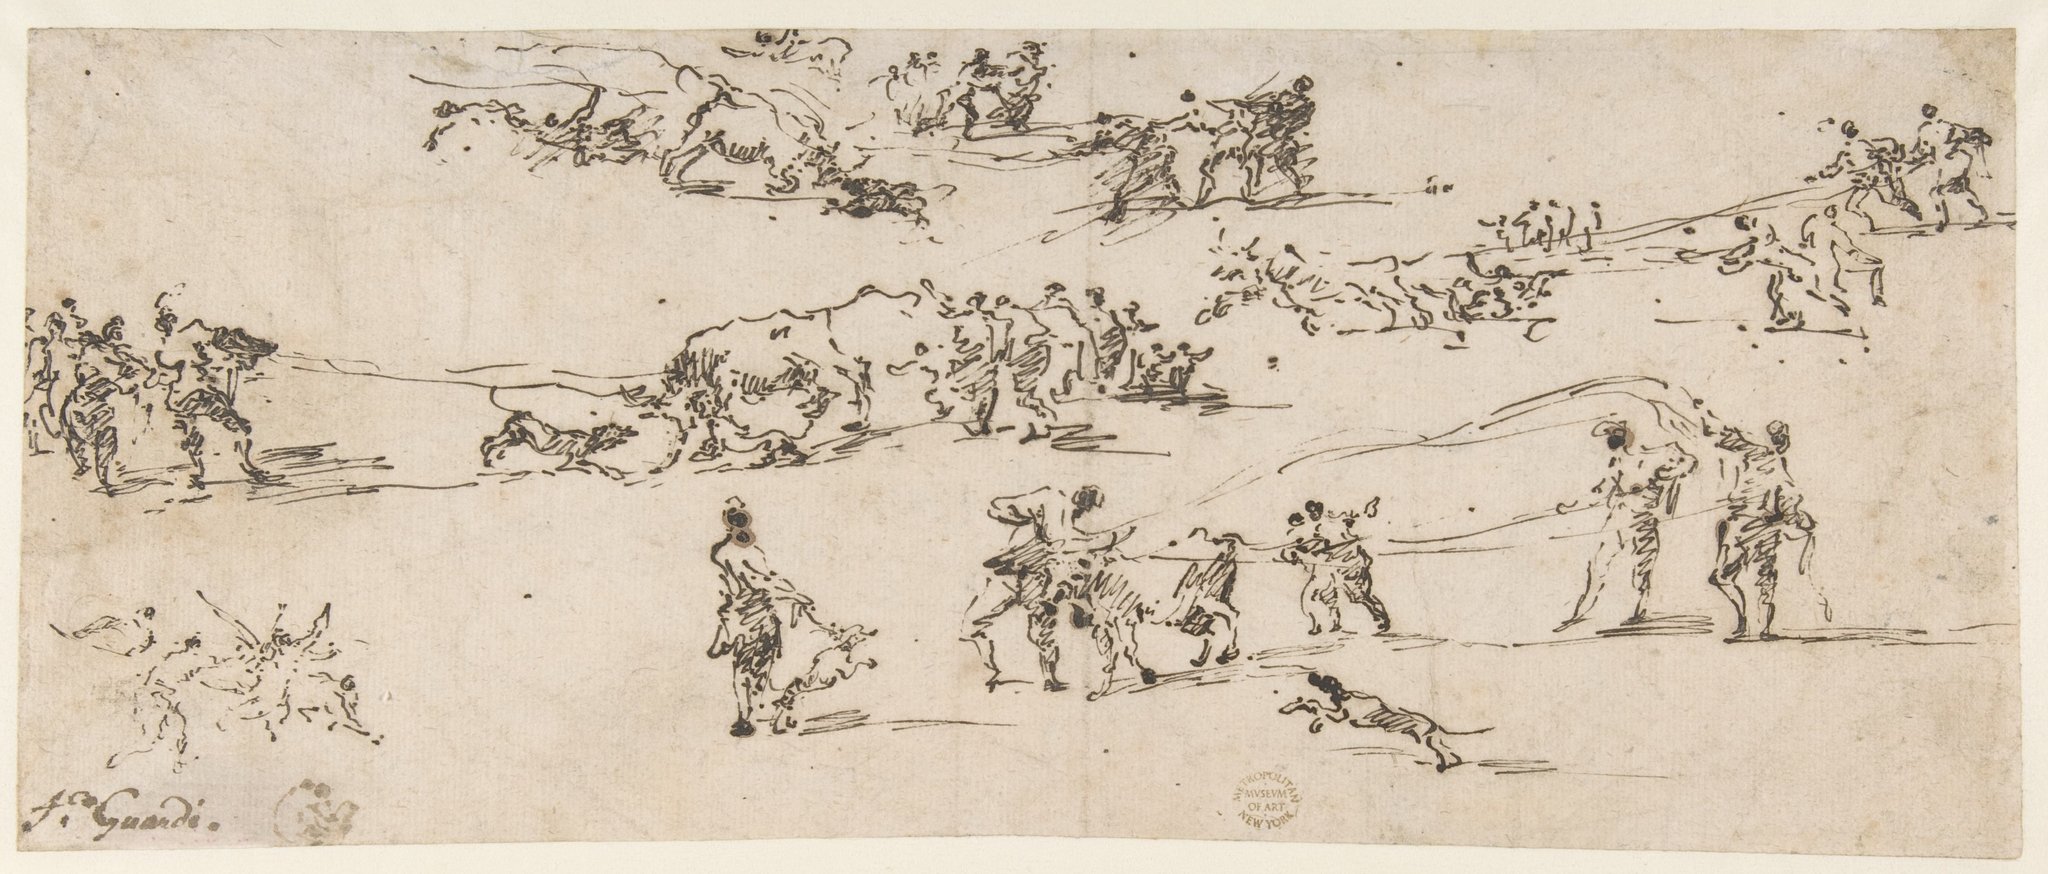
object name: drawing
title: Bullbaiting in a Venetian Piazza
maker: francesco guardi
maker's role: artist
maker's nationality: italian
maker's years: 1712-1793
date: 1712-1793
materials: ink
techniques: pen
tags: human figures,bulls,dogs,venice